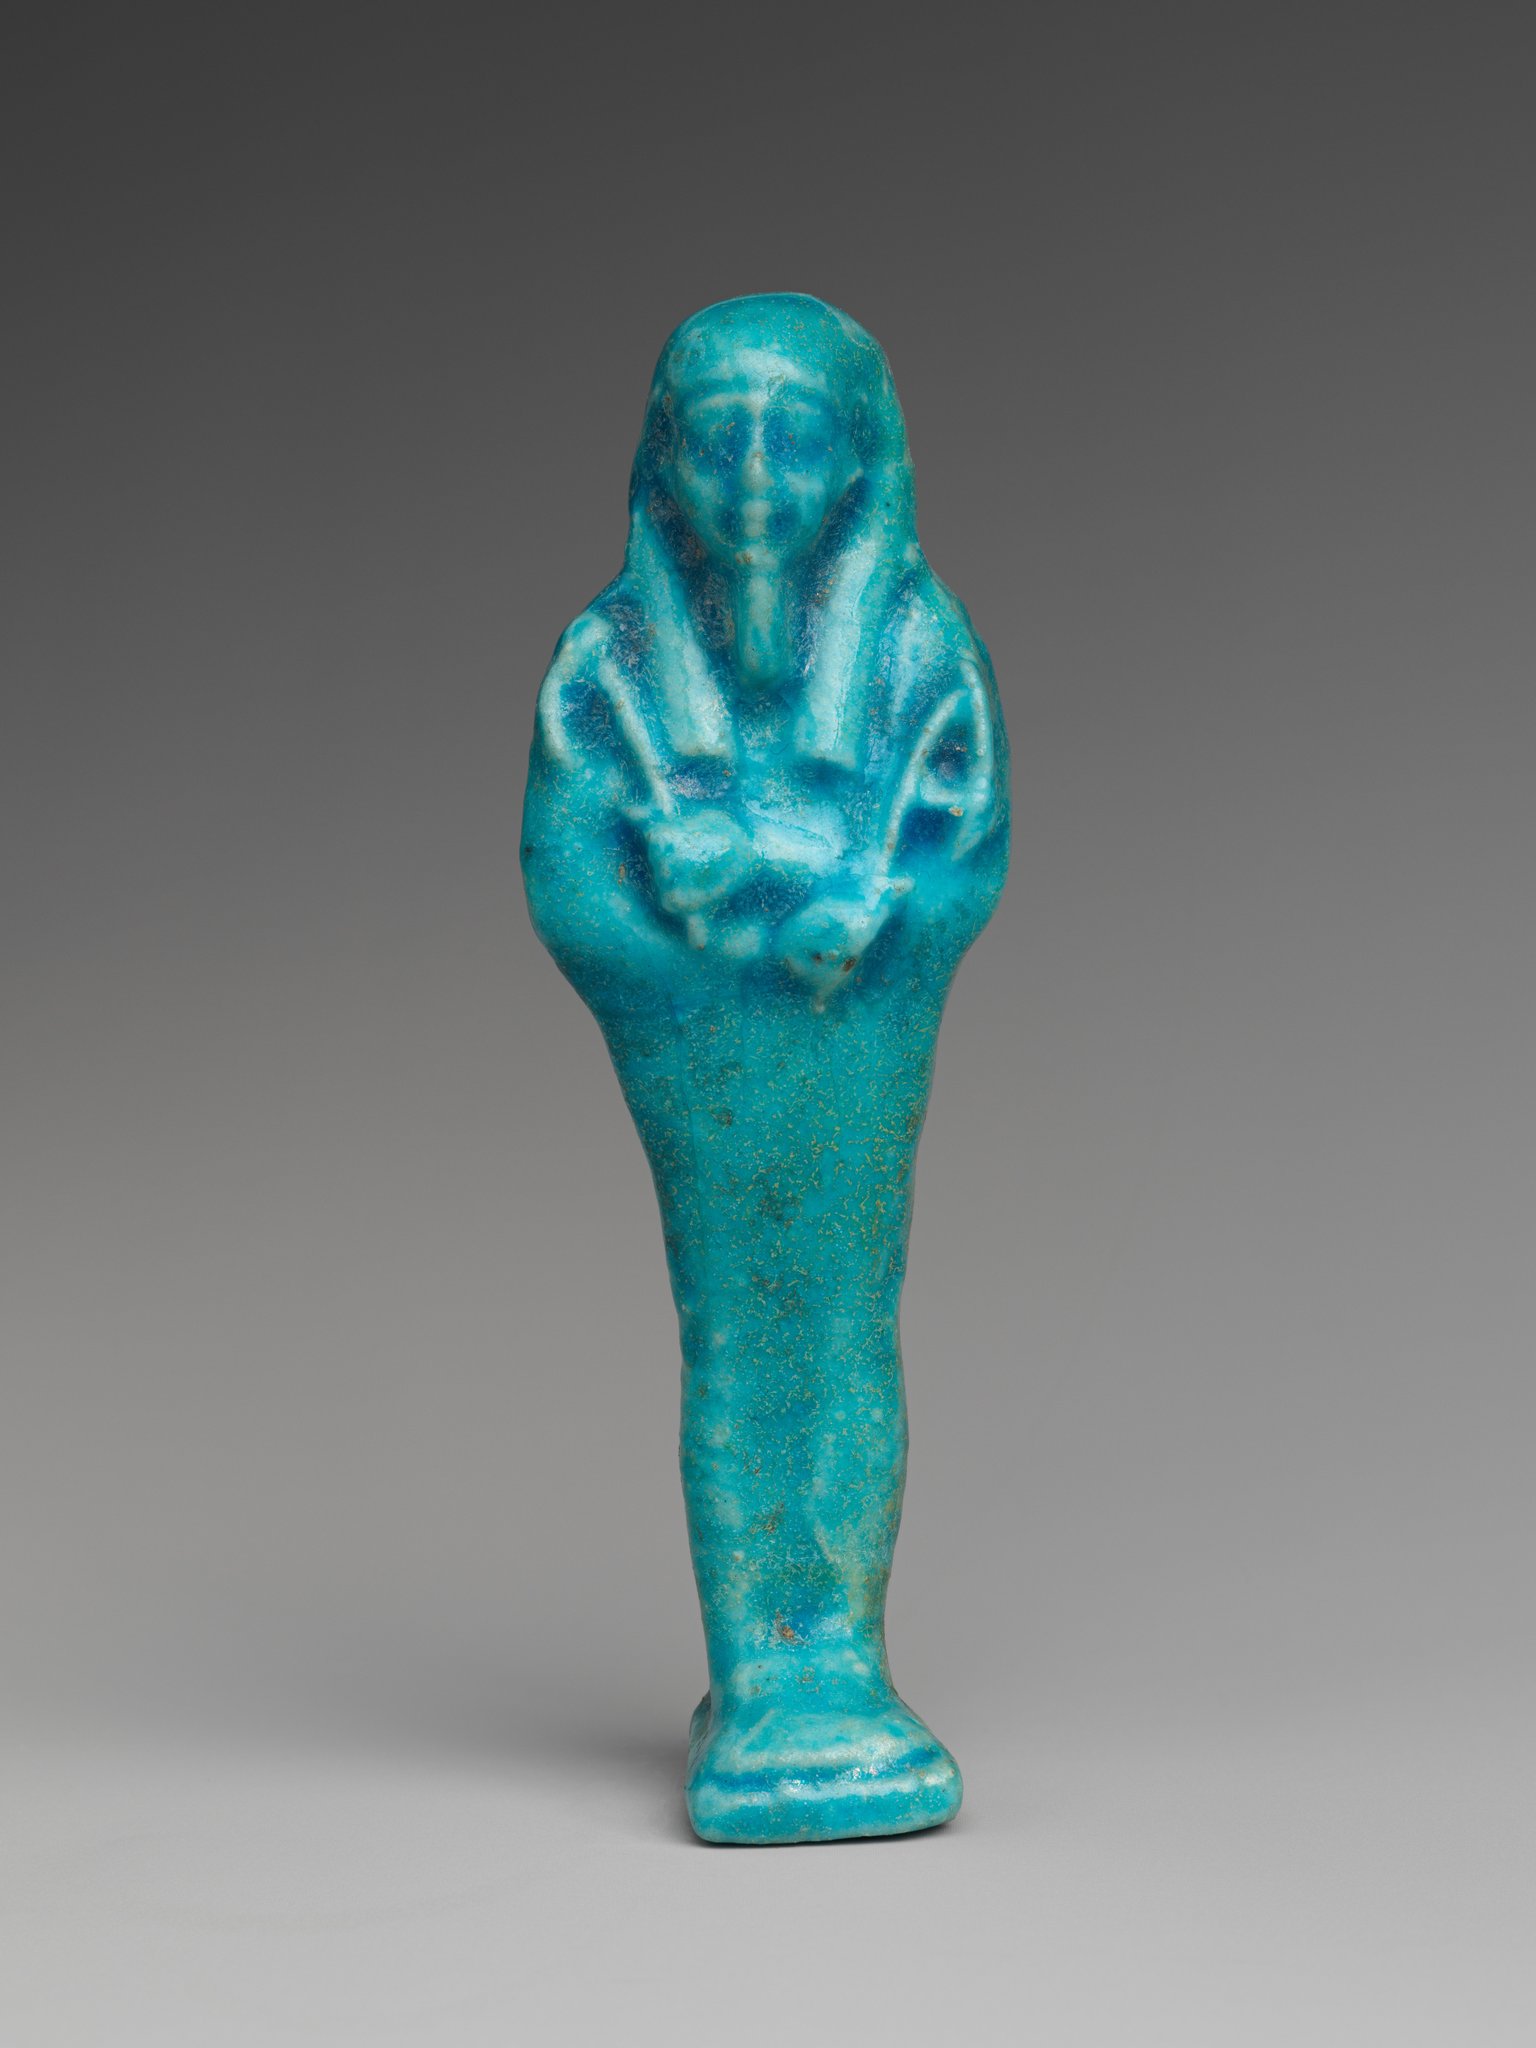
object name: shabti, petosiris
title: Shabti of Petosiris, son of Djedhor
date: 360-300 BCE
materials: faience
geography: egypt